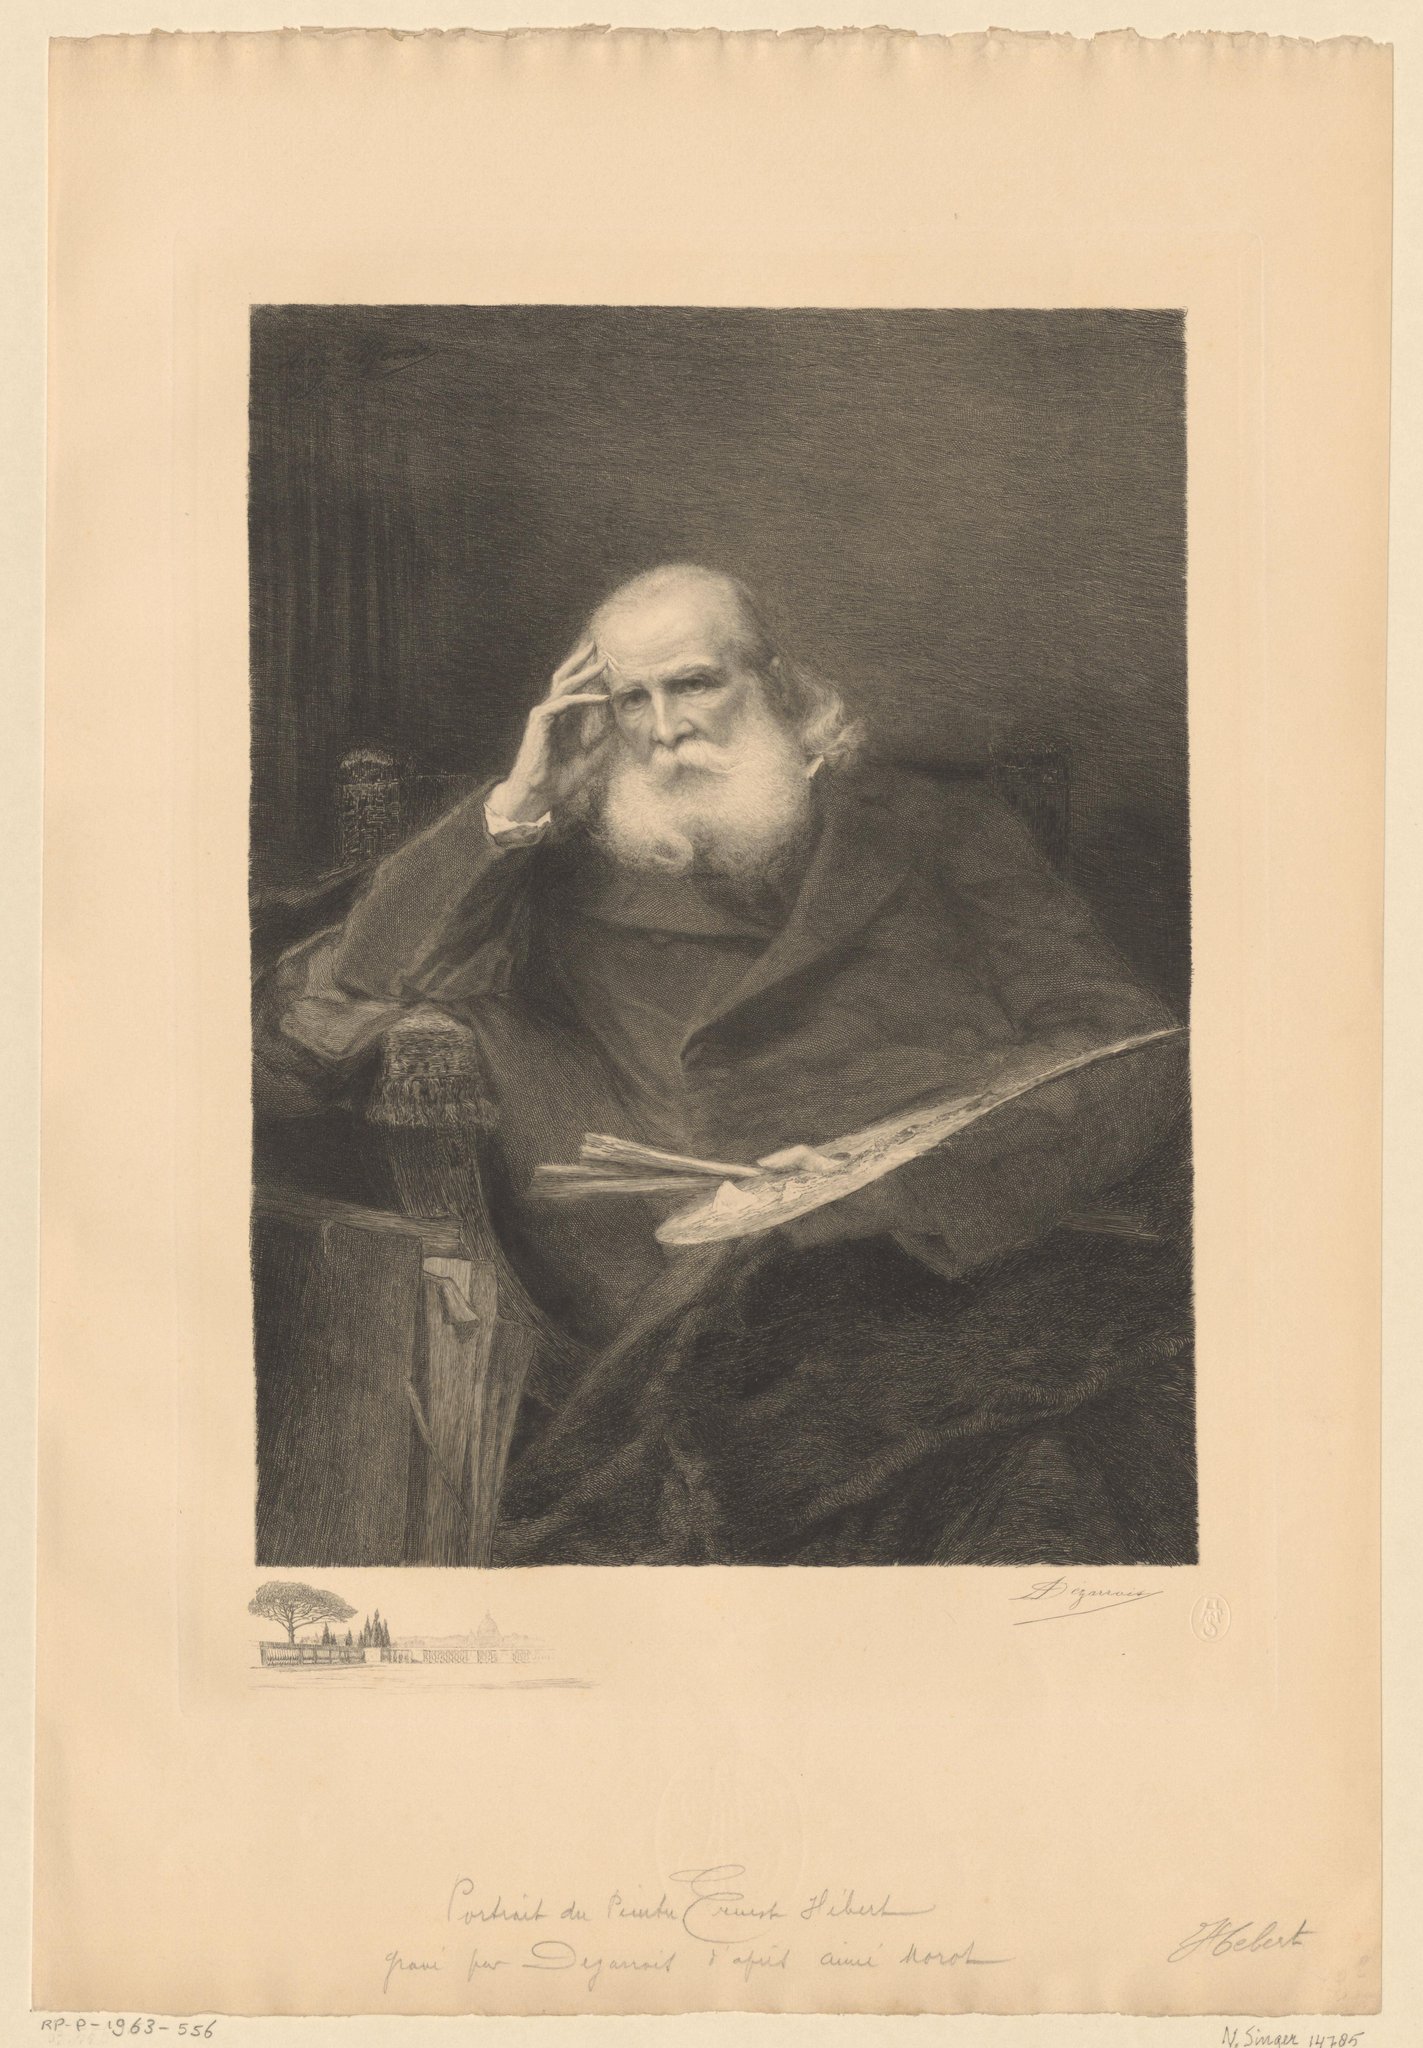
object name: print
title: Portret van Ernest Antoine Auguste Hébert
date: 1874-1939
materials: paper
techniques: etching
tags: painter, draughtsman, ernest antoine auguste hébert, historical persons, portrait, self-portrait of painter, tools, implements of painter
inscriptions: collector's mark: Lugt 2228, collector's mark: Lugt 121